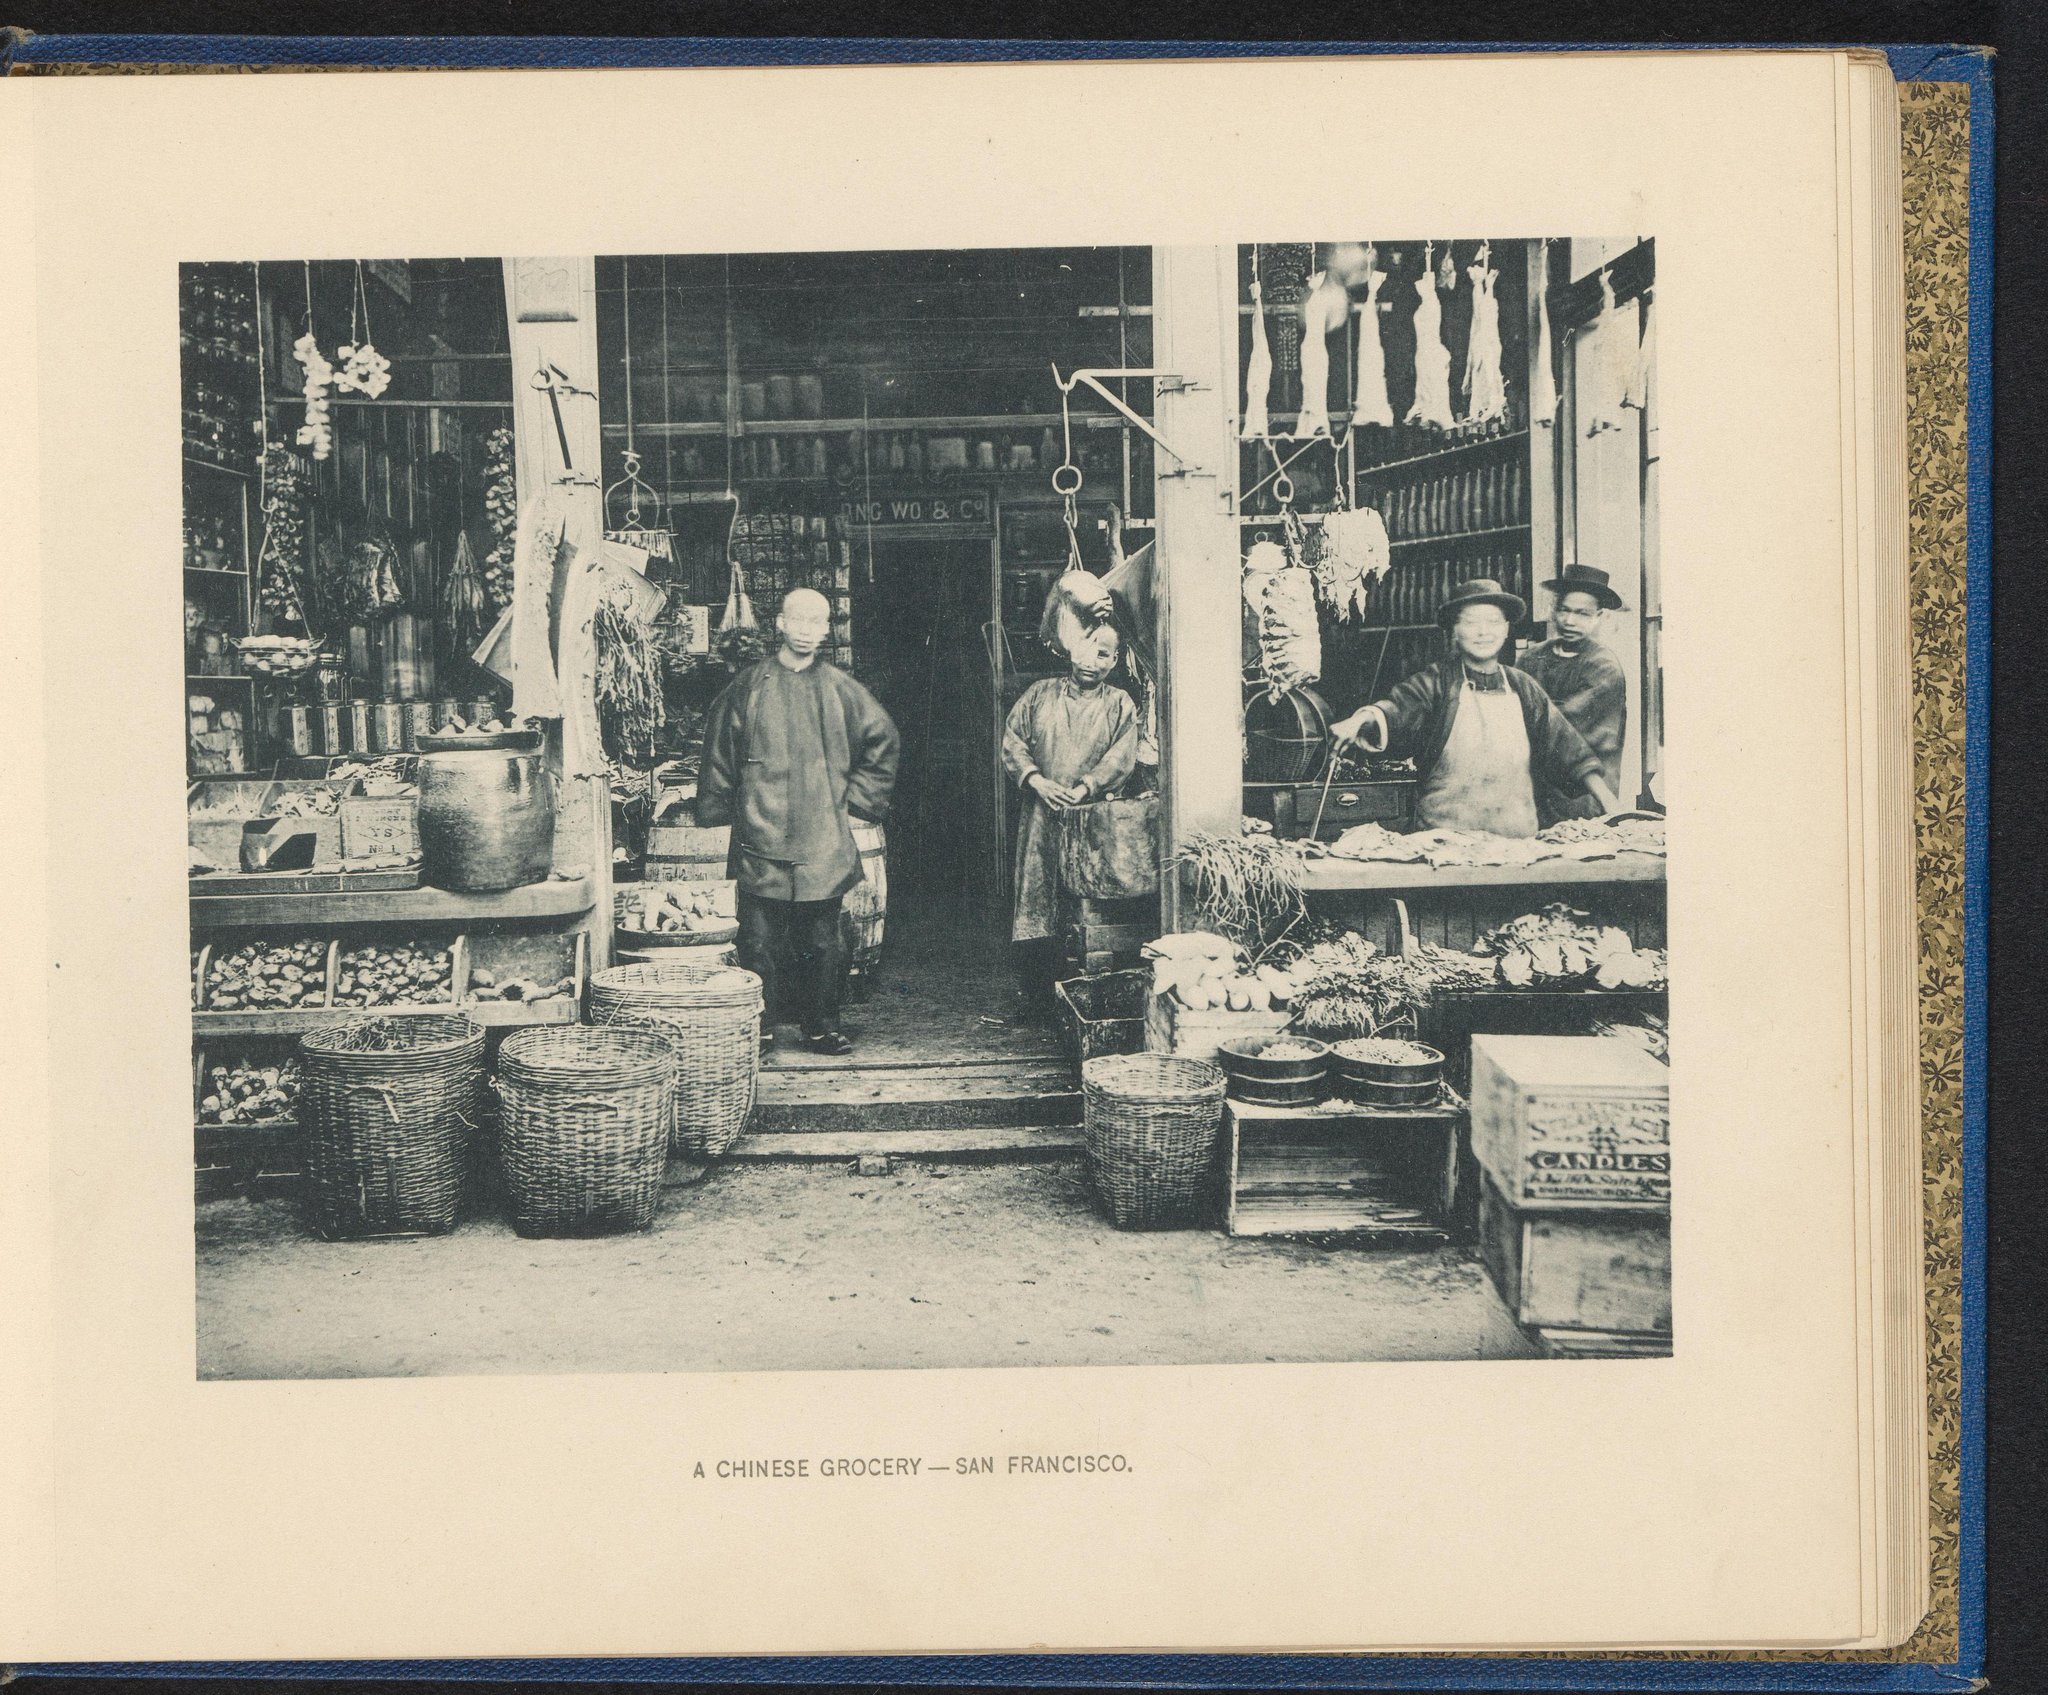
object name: page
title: A Chines Grocery - San Francisco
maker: Anonymous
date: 1883-1893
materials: paper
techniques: photograph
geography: san francisco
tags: shop, store